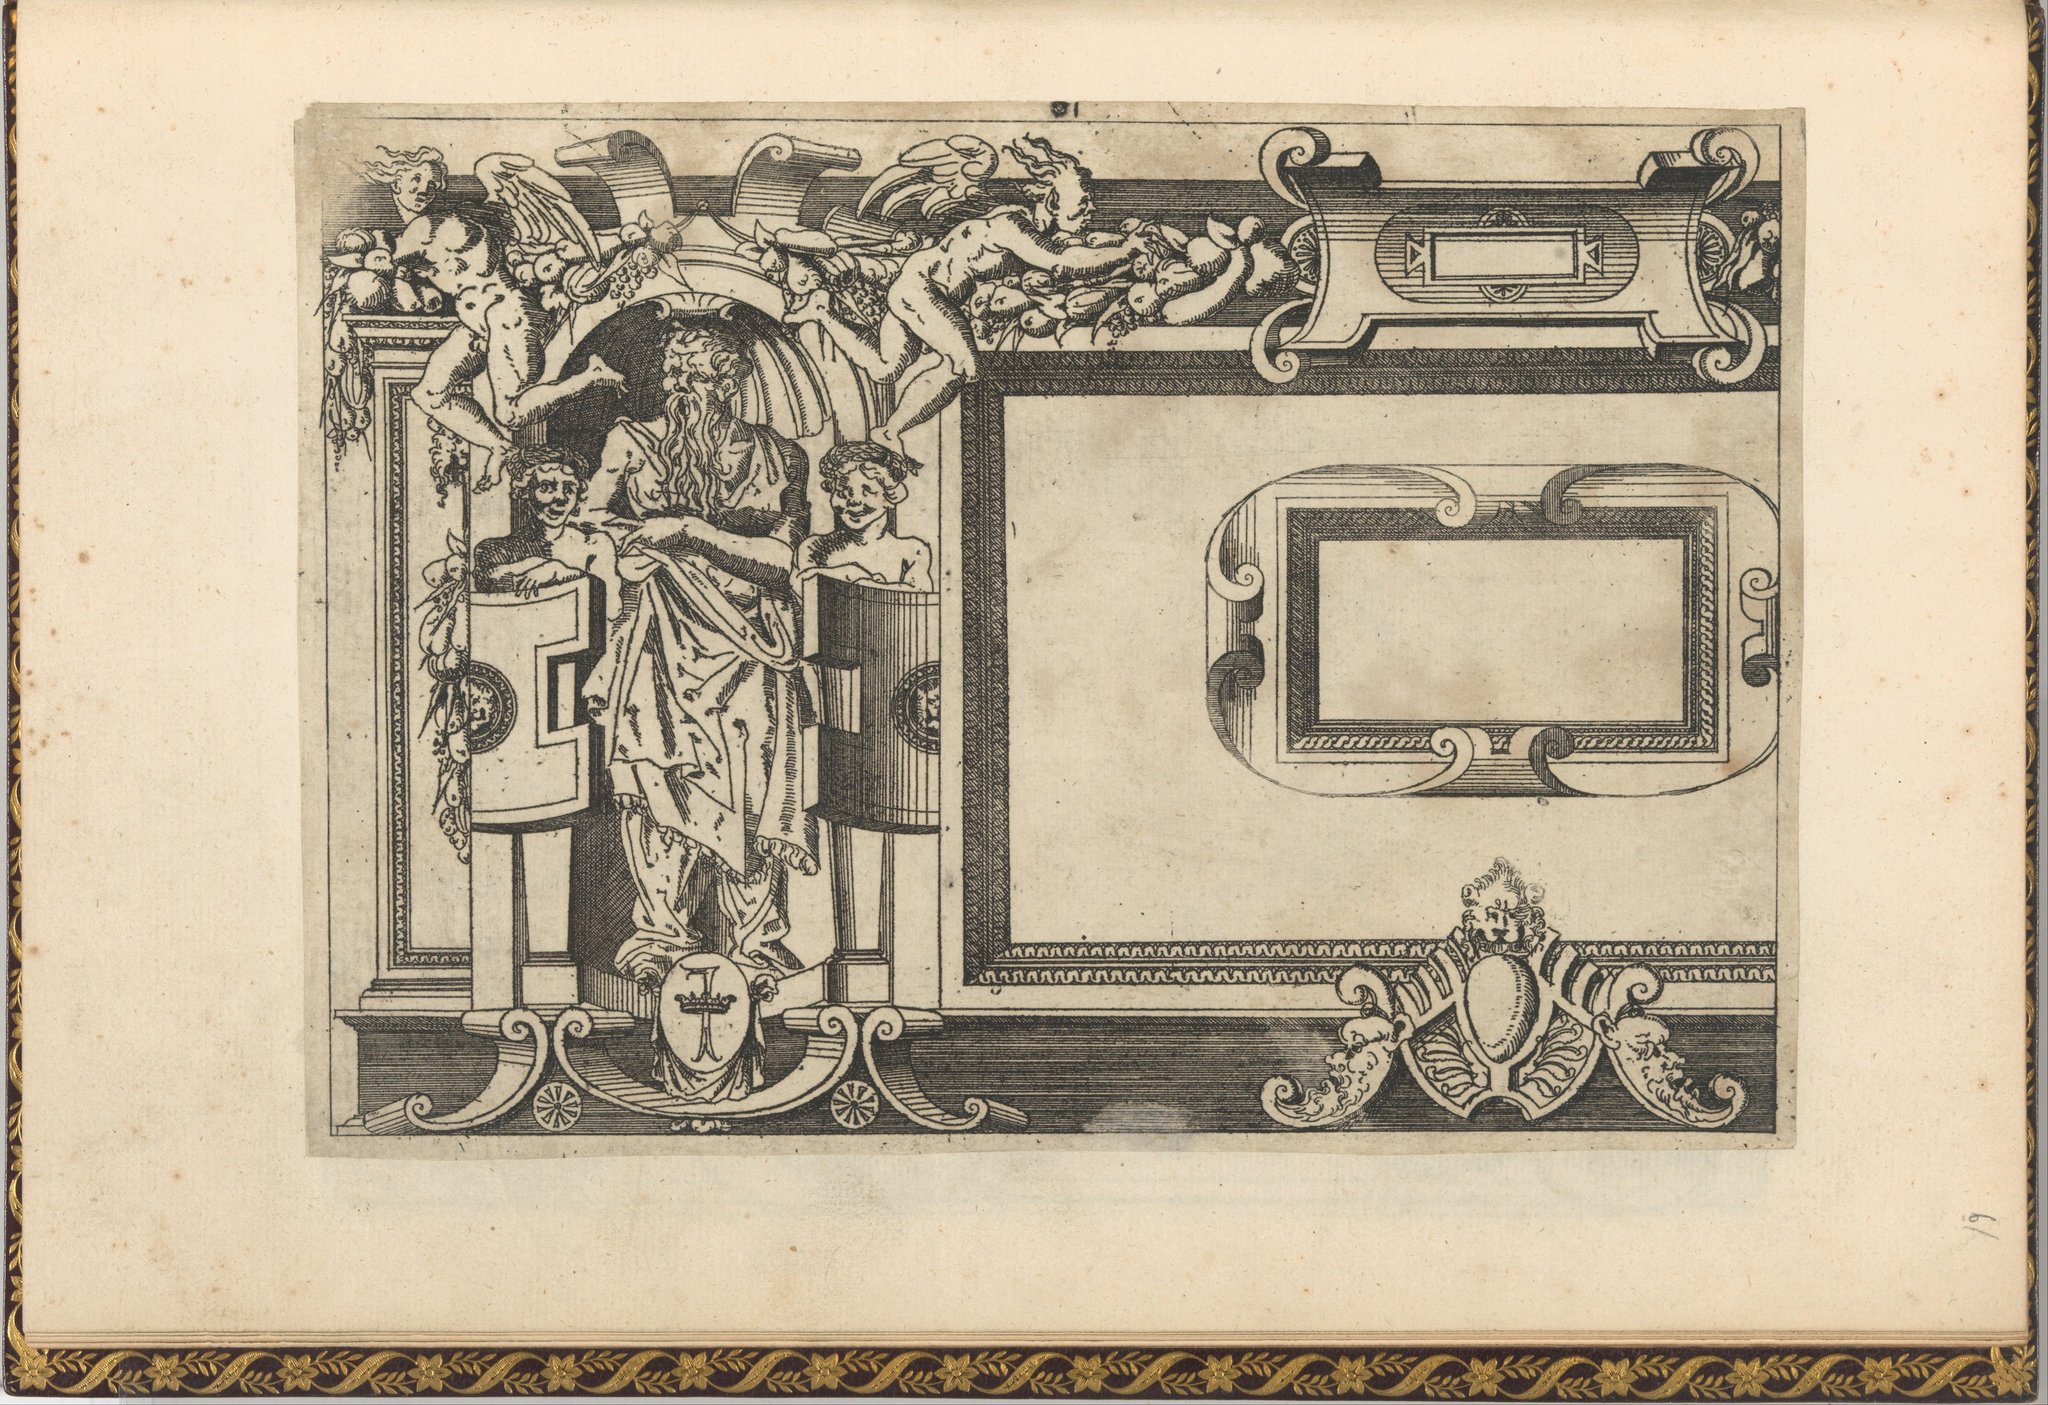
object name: book print ornament architecture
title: Designs for frames after the Galerie de François 1er at Fontainebleau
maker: jacques androuet du cerceau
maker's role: artist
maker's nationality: french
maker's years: 1510-1585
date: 1542-1547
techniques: etching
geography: france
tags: ornament